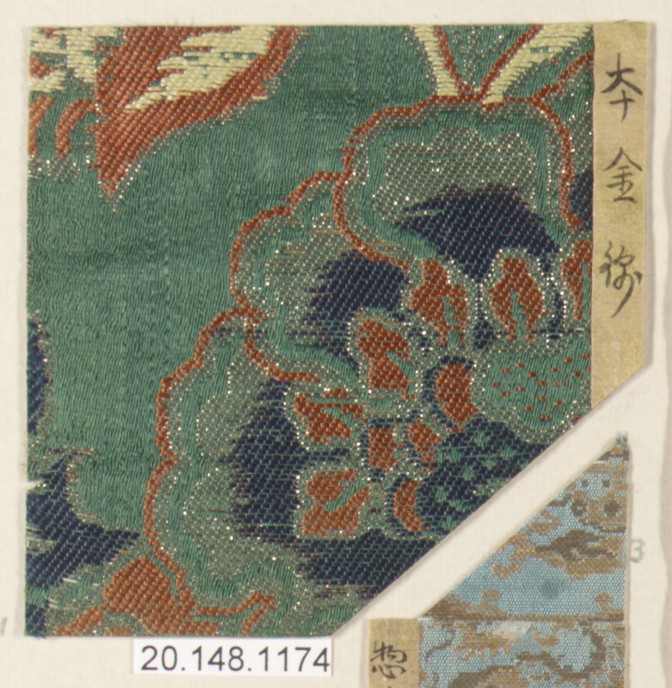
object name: piece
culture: japanese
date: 1601-1700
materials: silk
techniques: compound weave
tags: flowers